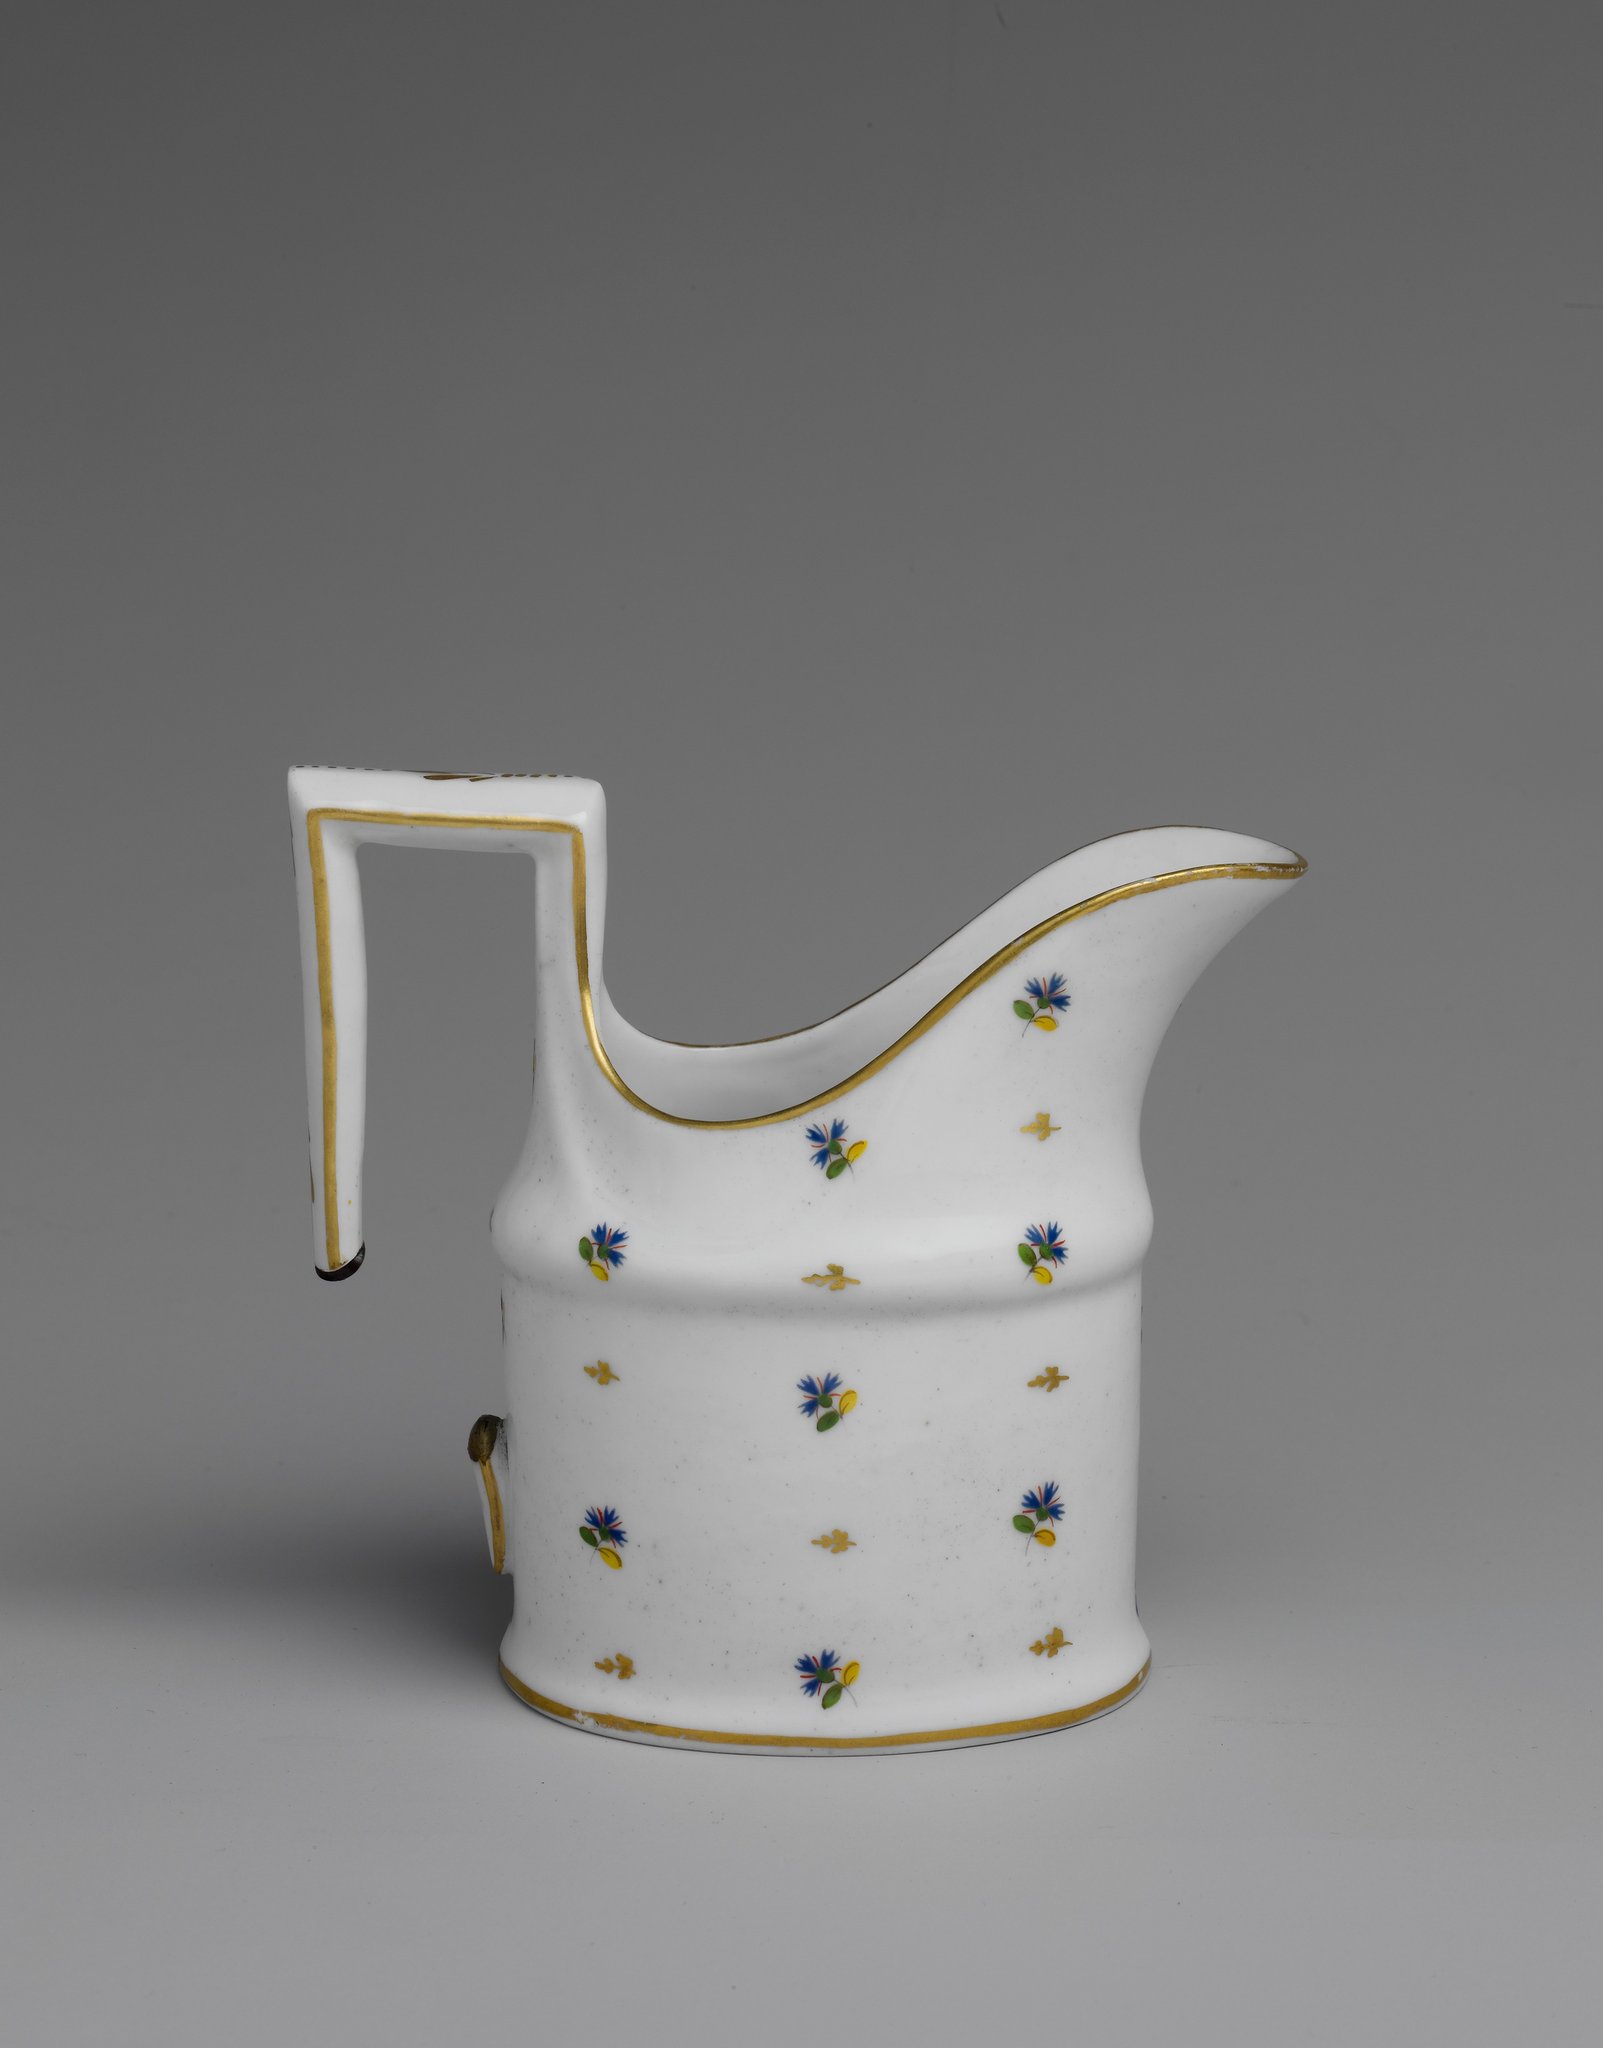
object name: cream pitcher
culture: french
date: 1780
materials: porcelain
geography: france